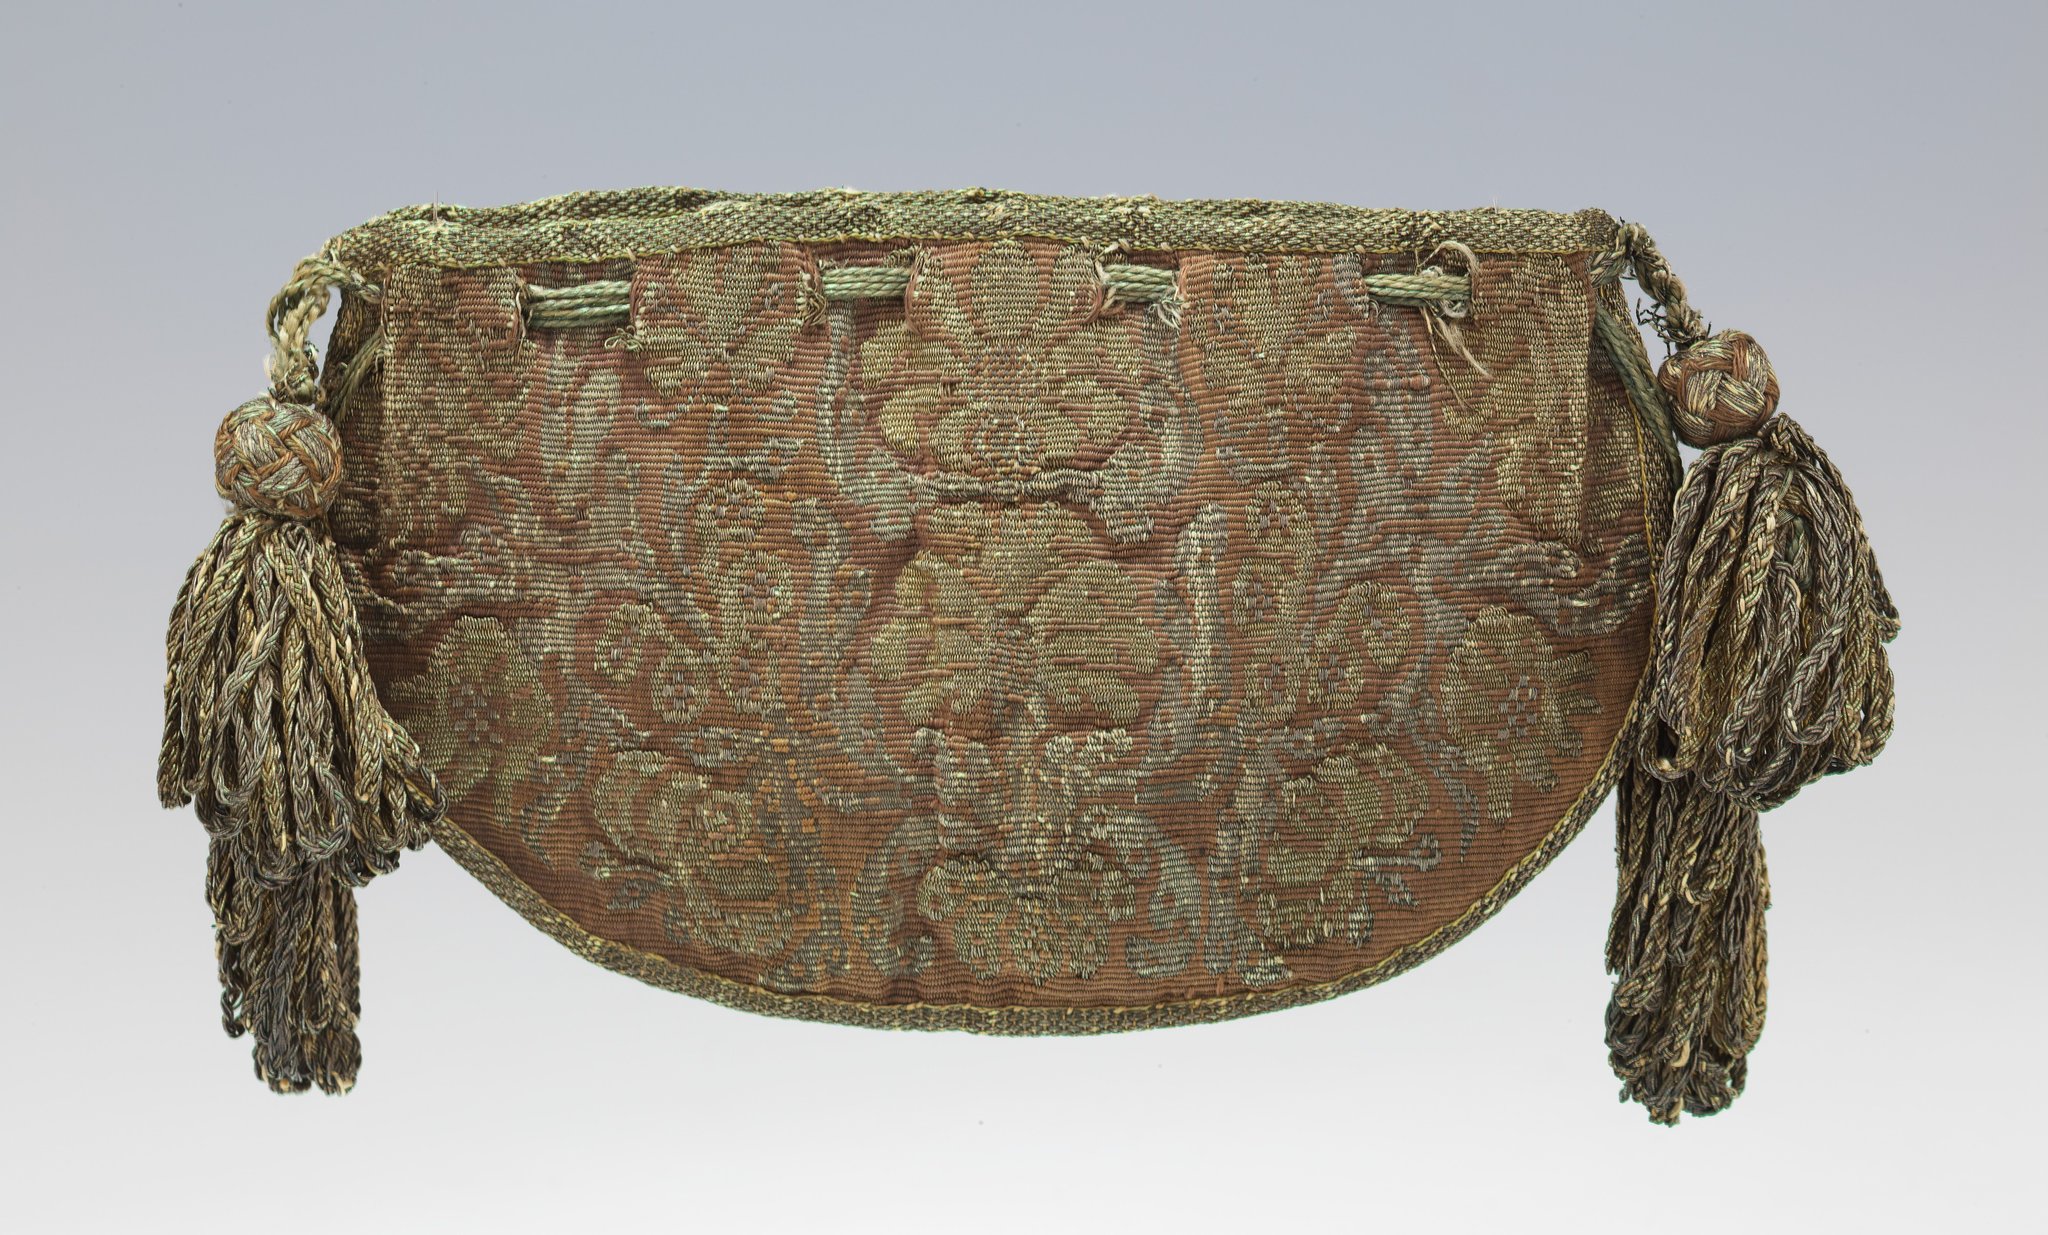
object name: purse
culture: german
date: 1676-1700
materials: metal, silk